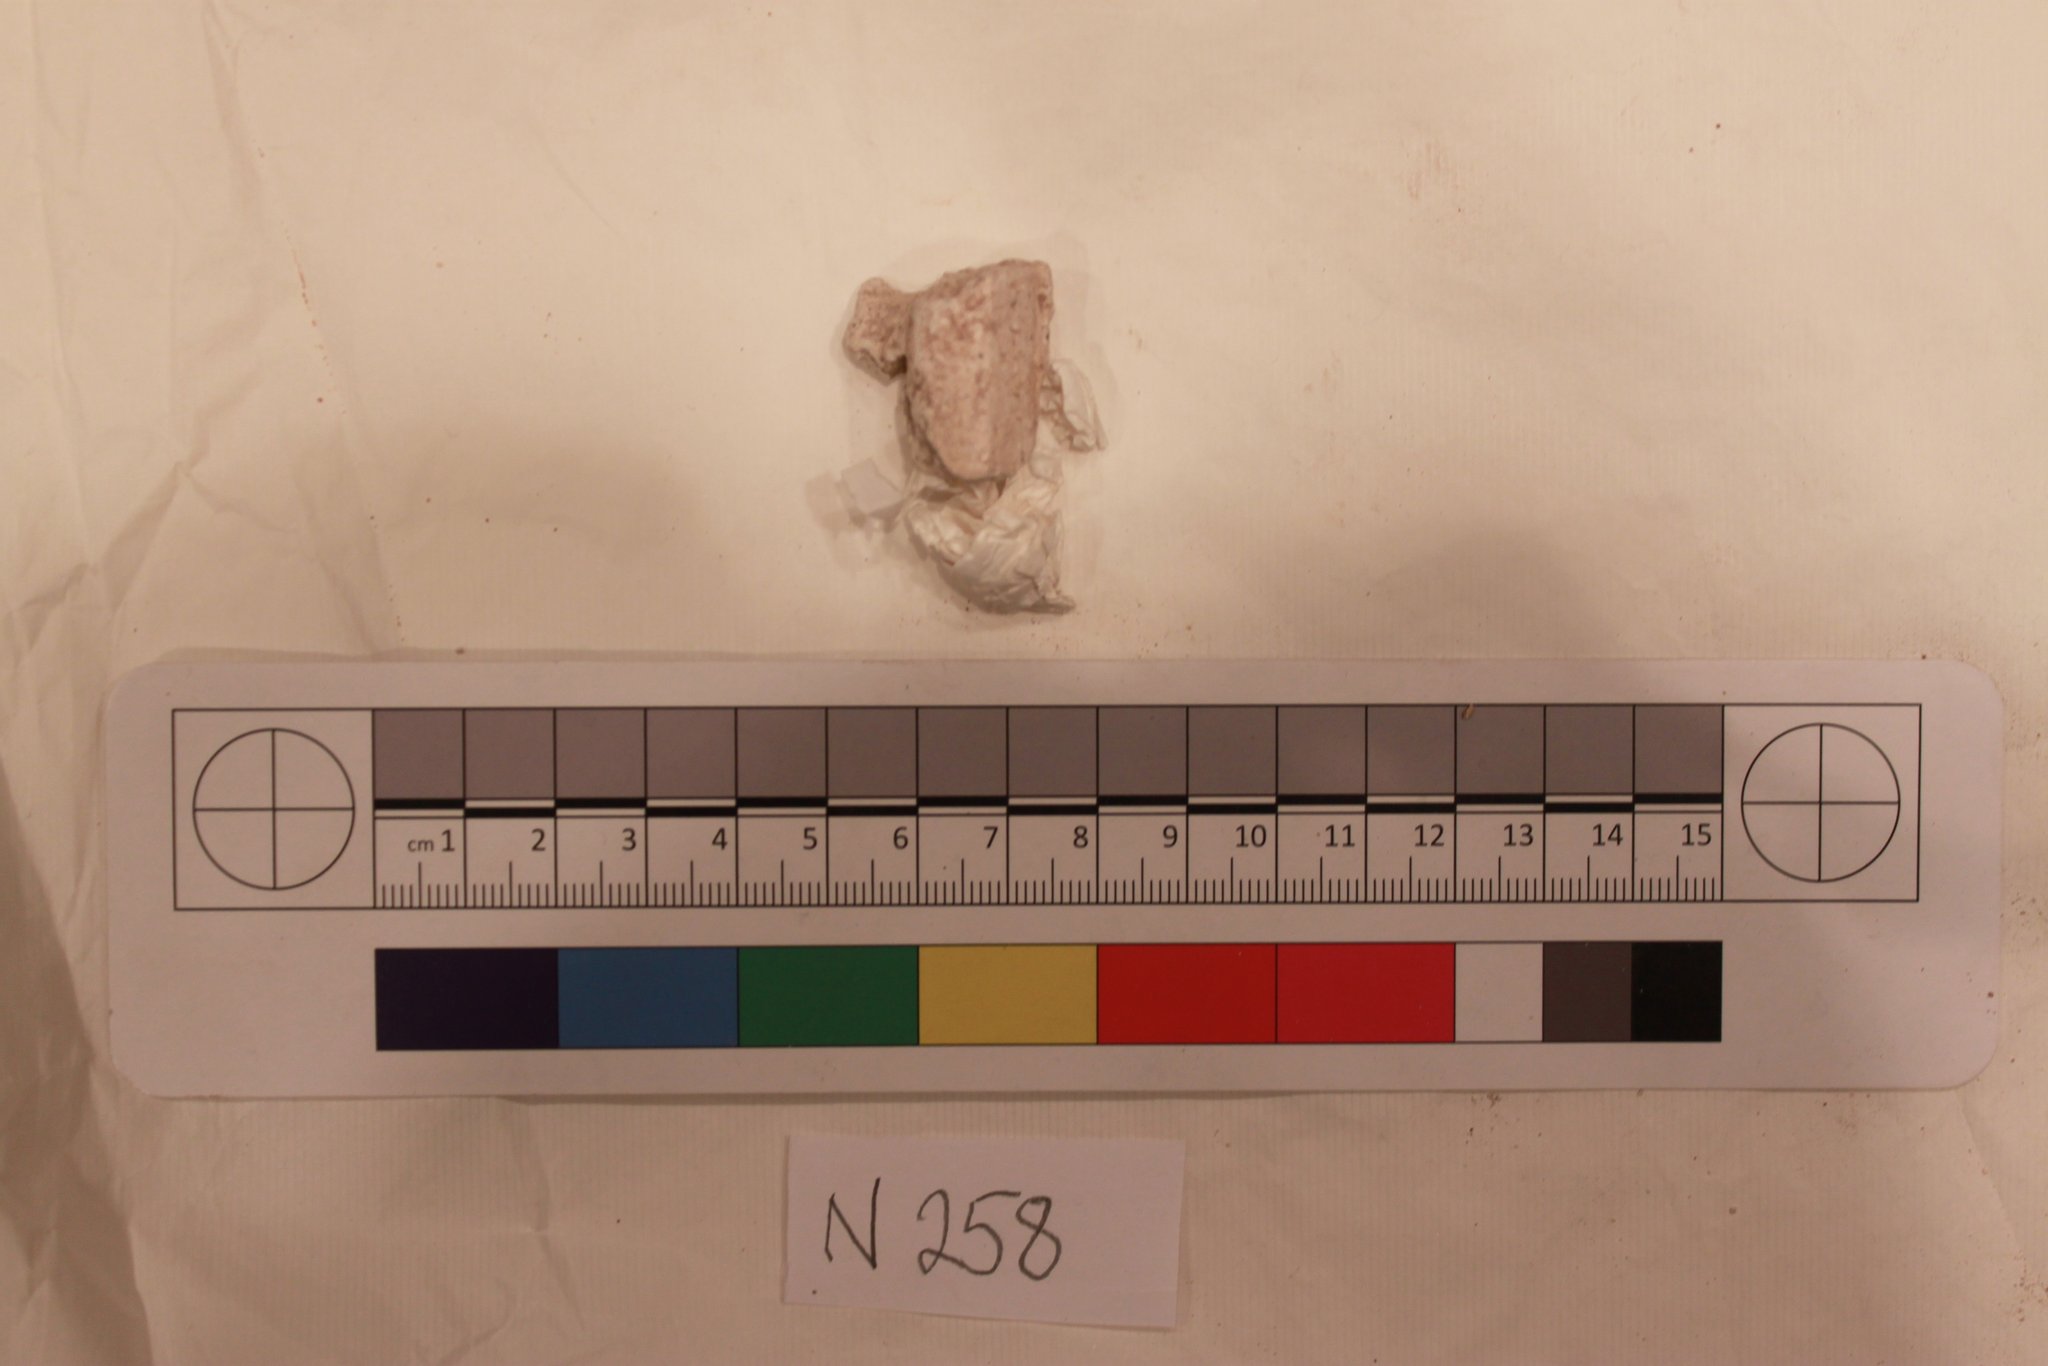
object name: fragment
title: Stucco Fragment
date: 701-1200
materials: plaster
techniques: carving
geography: iran